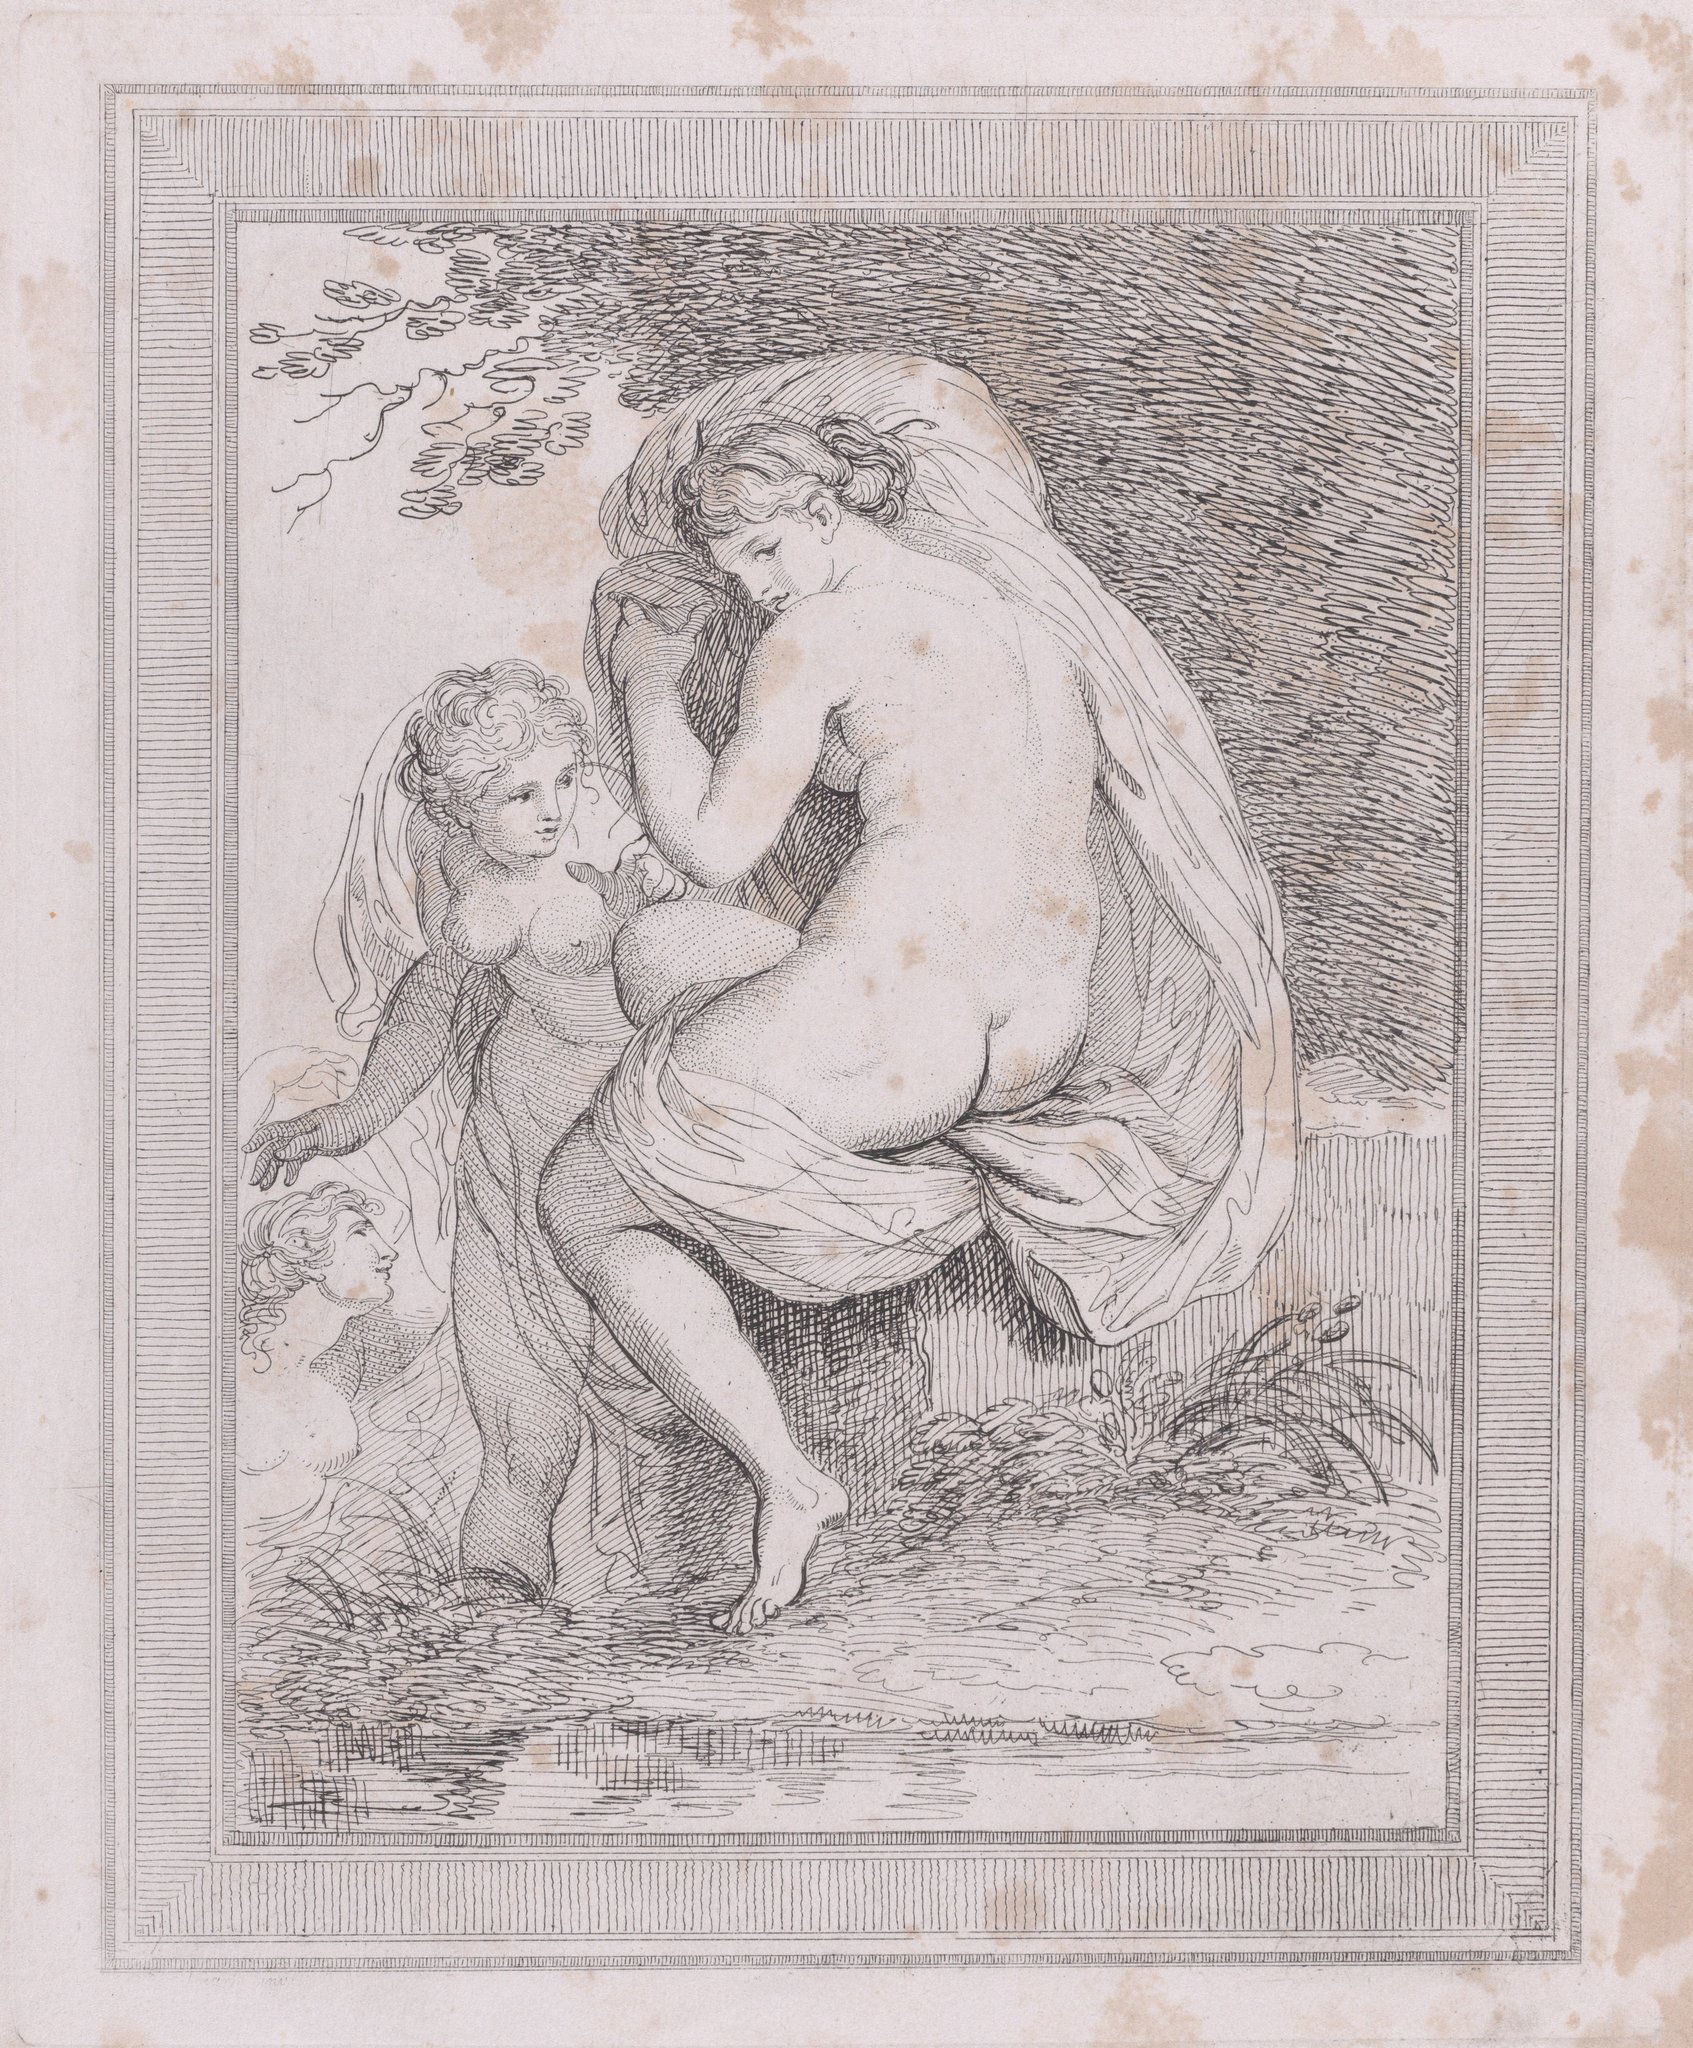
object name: print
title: A Nymph Drying Herself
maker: thomas rowlandson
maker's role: artist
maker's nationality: british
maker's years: 1757-1827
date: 1790-1799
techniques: etching